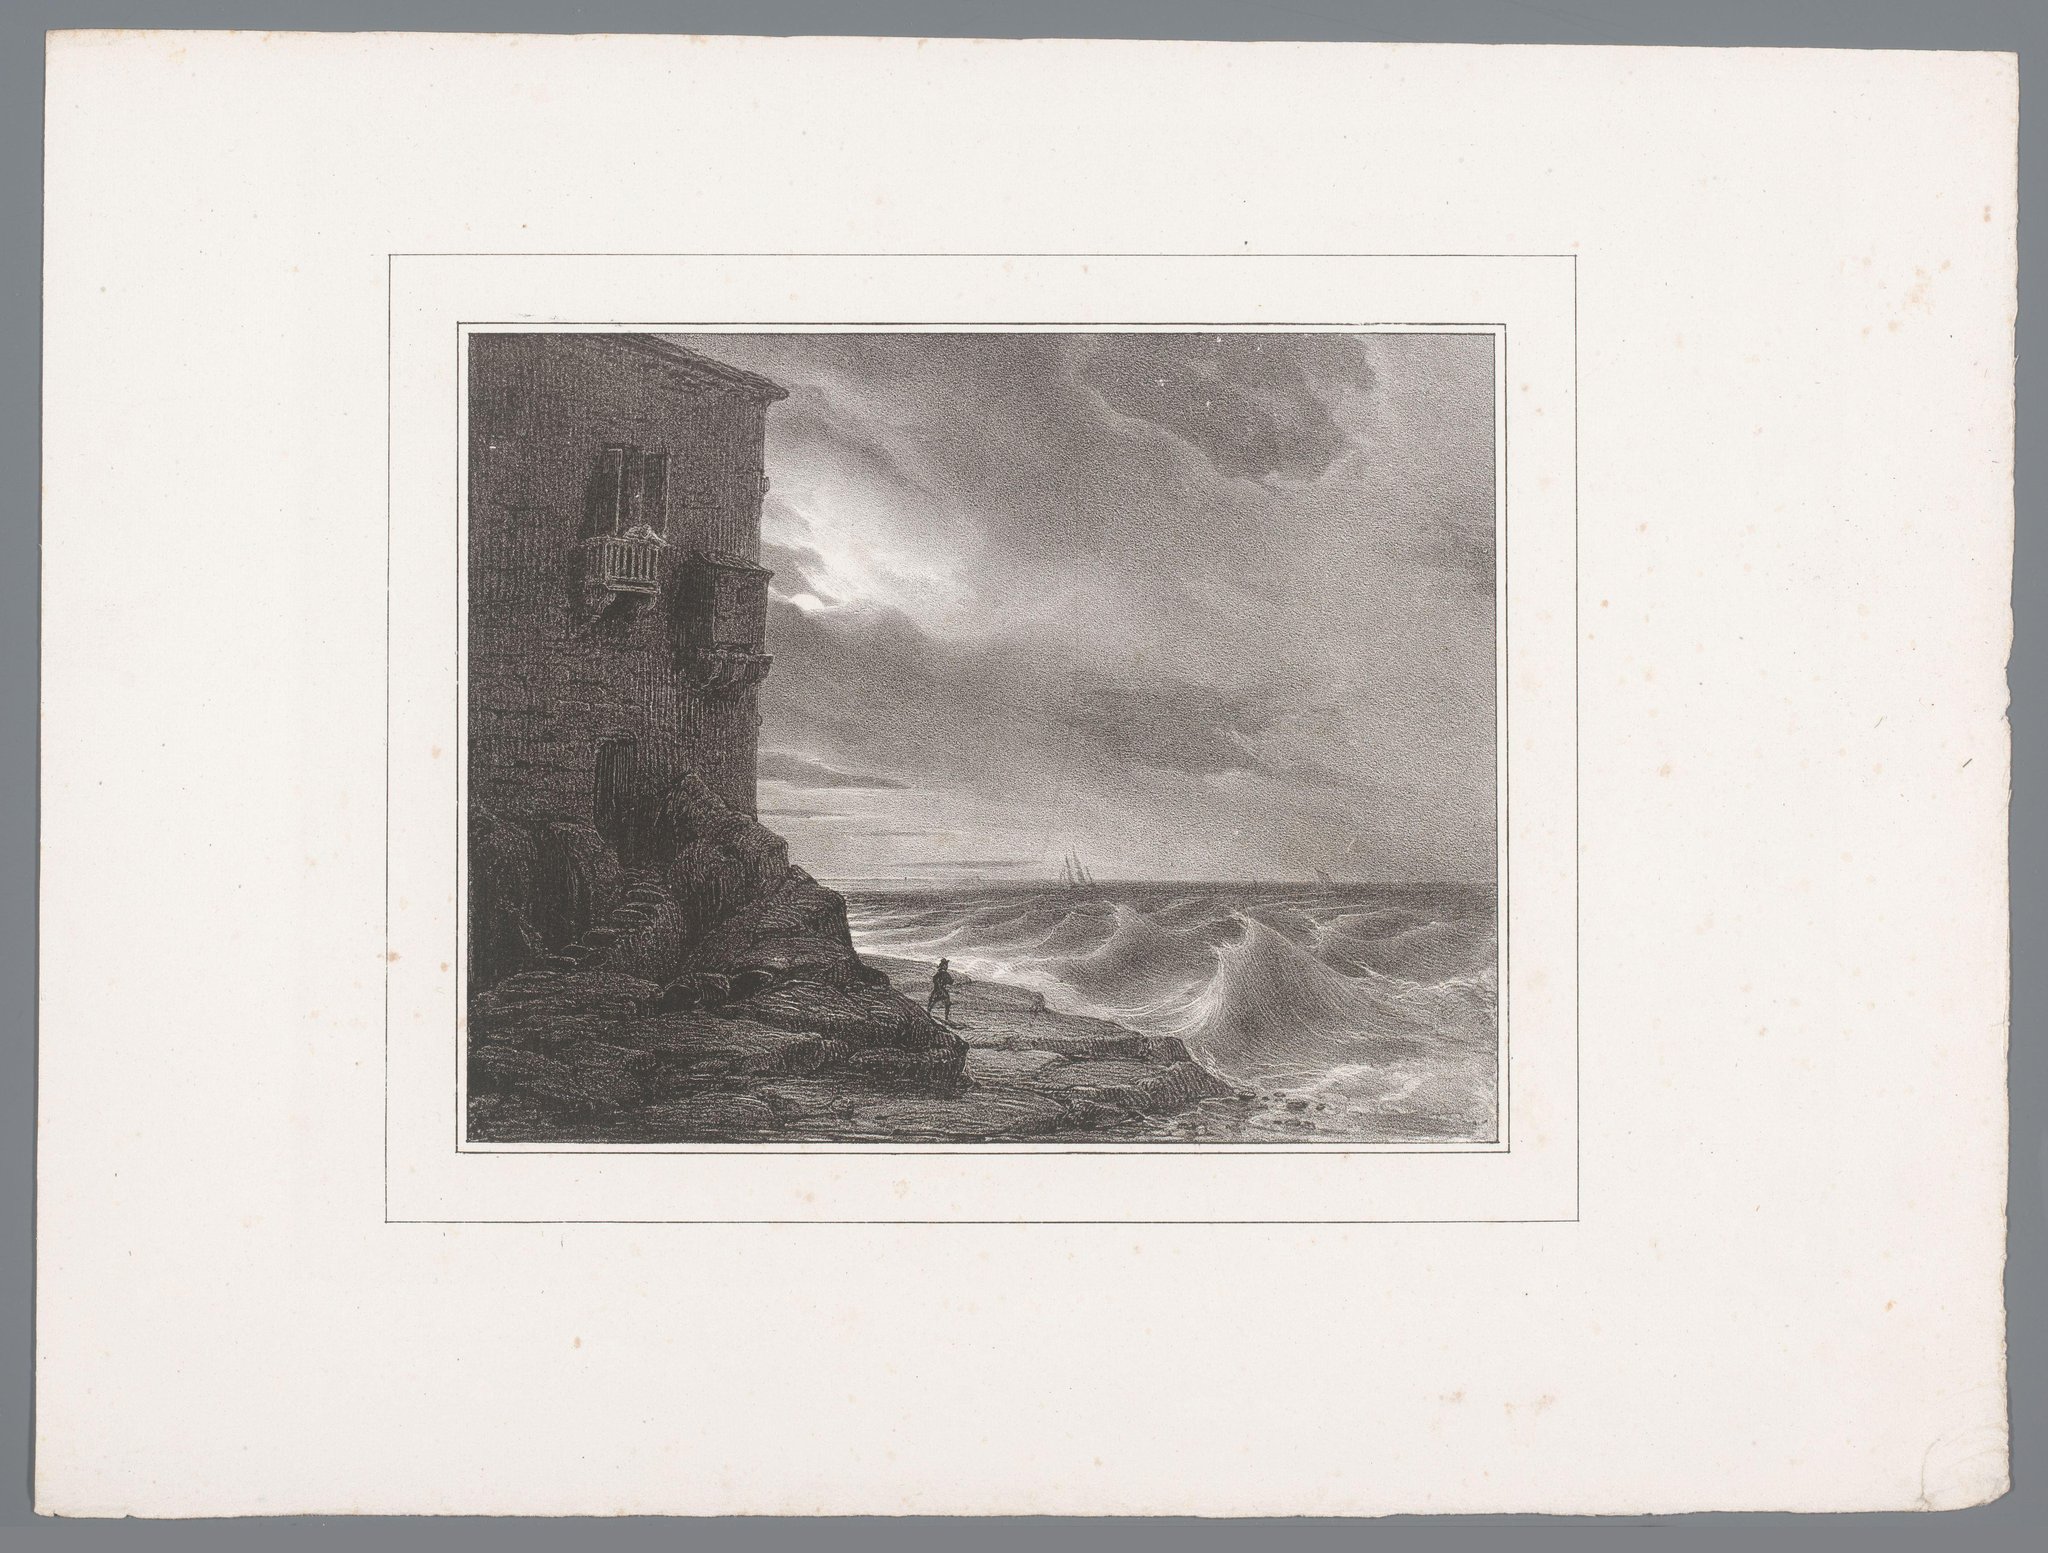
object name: print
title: Huis aan de kust bij maanlicht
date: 1824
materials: paper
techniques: lithograph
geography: paris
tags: parts (of house or building), moonlight, sea (seascape) (+ landscape with figures, staffage)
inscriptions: collector's mark: Lugt 2228a